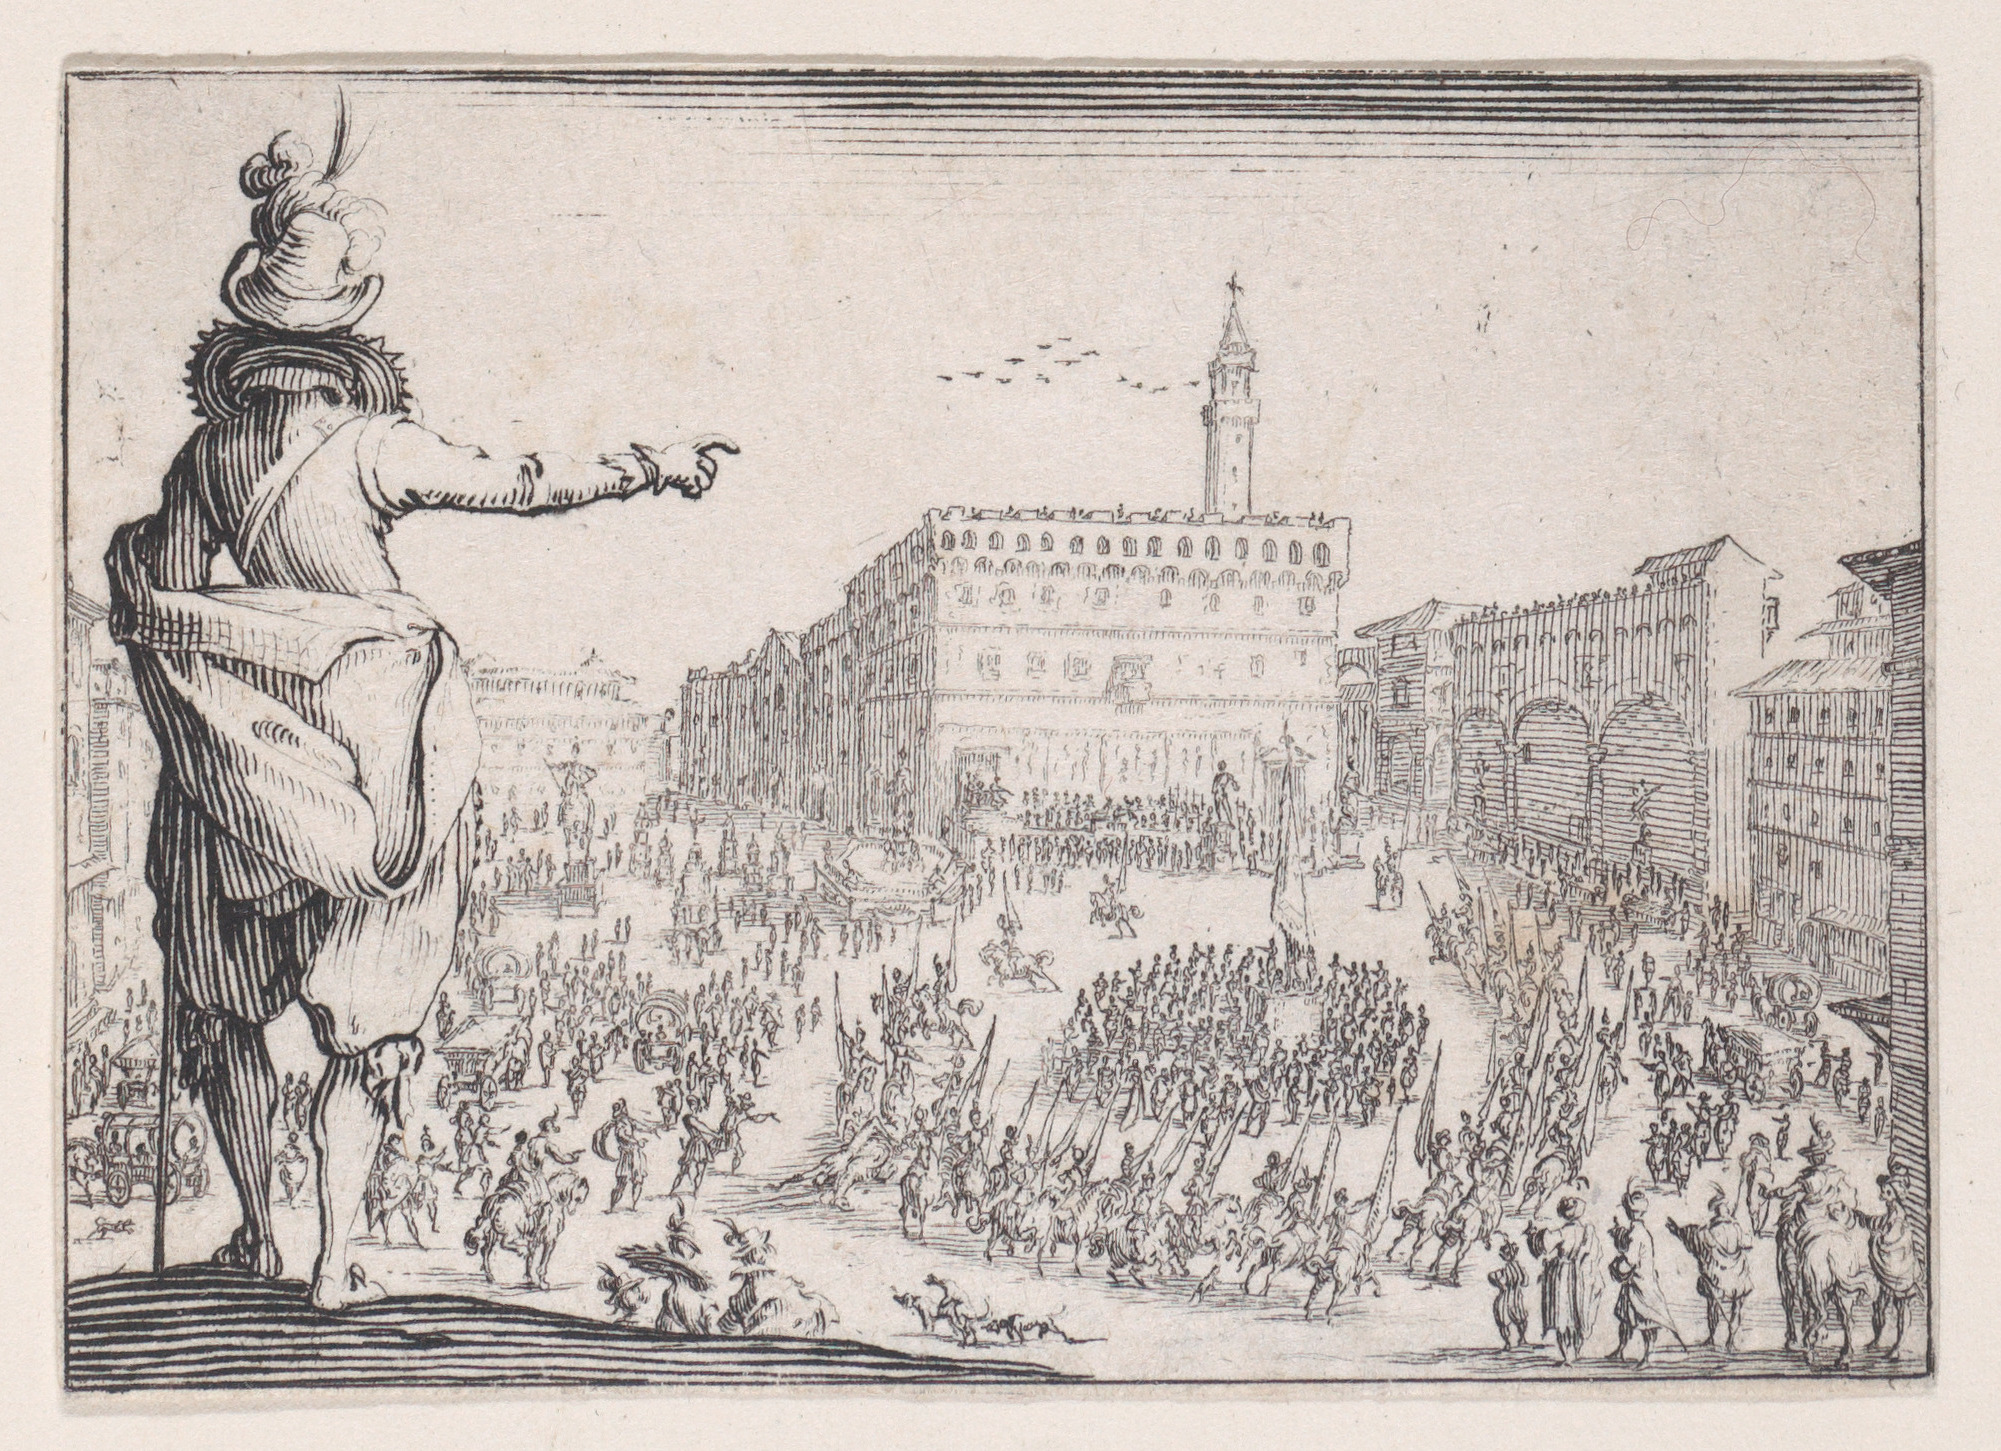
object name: print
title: Une Fête sur la Place de la Signoria a Florence (A Festival on the Piazza della Signoria in Florence), from "Les Caprices" Series A, The Florence Set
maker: jacques callot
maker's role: artist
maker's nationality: french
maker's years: 1592-1635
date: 1617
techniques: etching